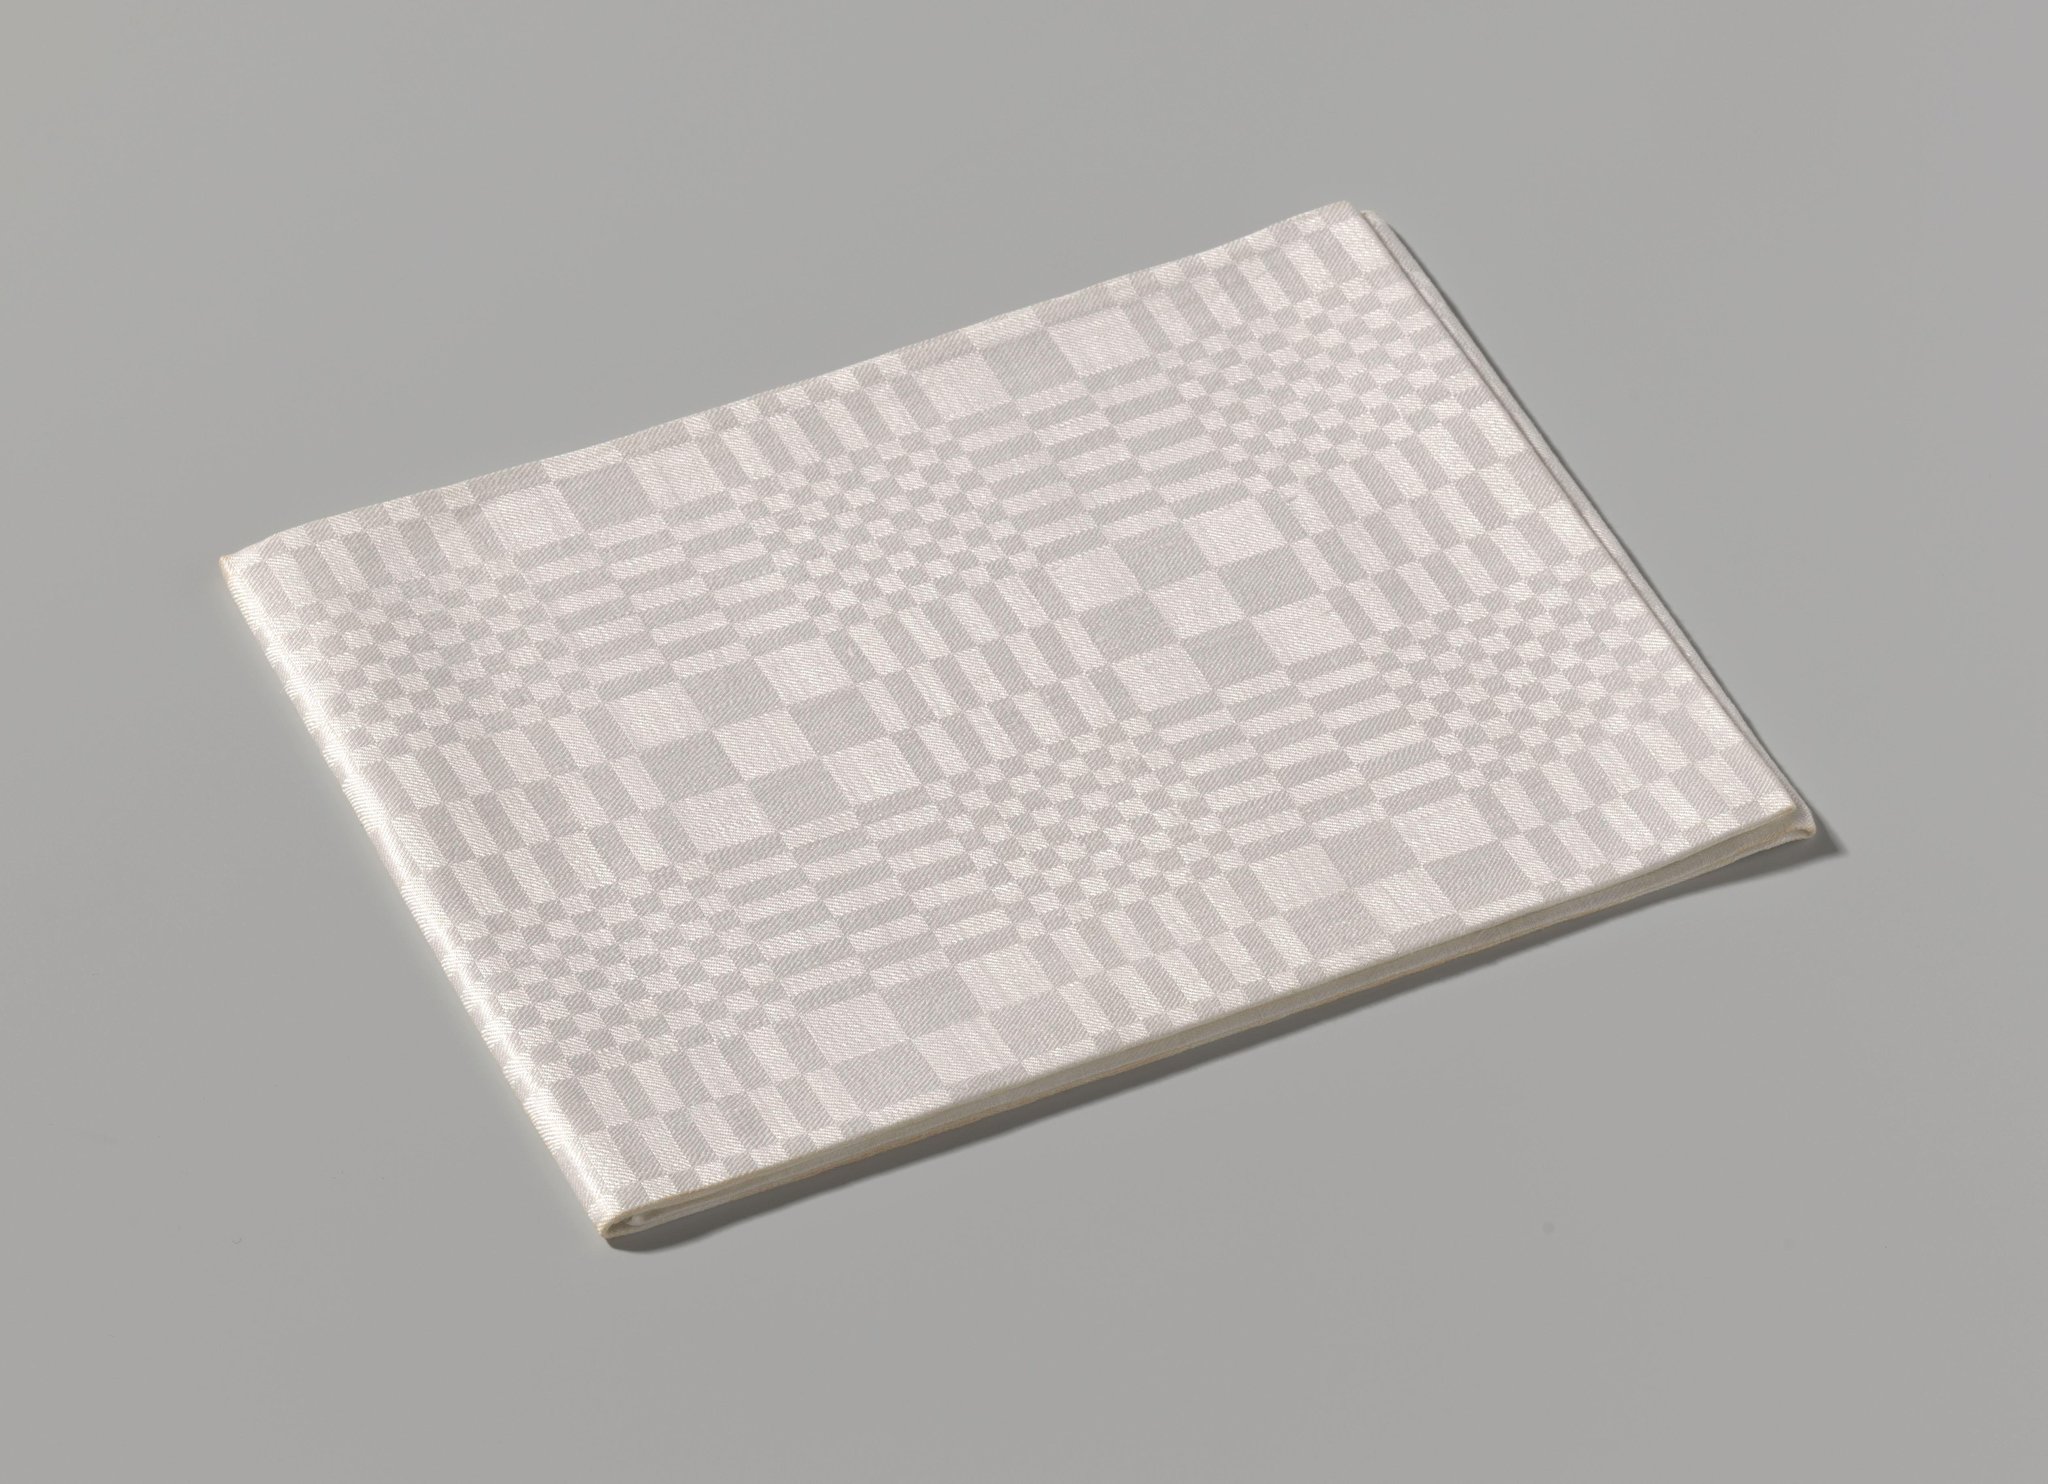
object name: napkin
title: Servet van linnen met pellenpatroon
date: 1784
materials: linen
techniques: twill, peeled fabric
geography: northern netherlands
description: wit linnen servet met pellen patroon, z.g. Engelse garderobe, merk WS 104 en 1784